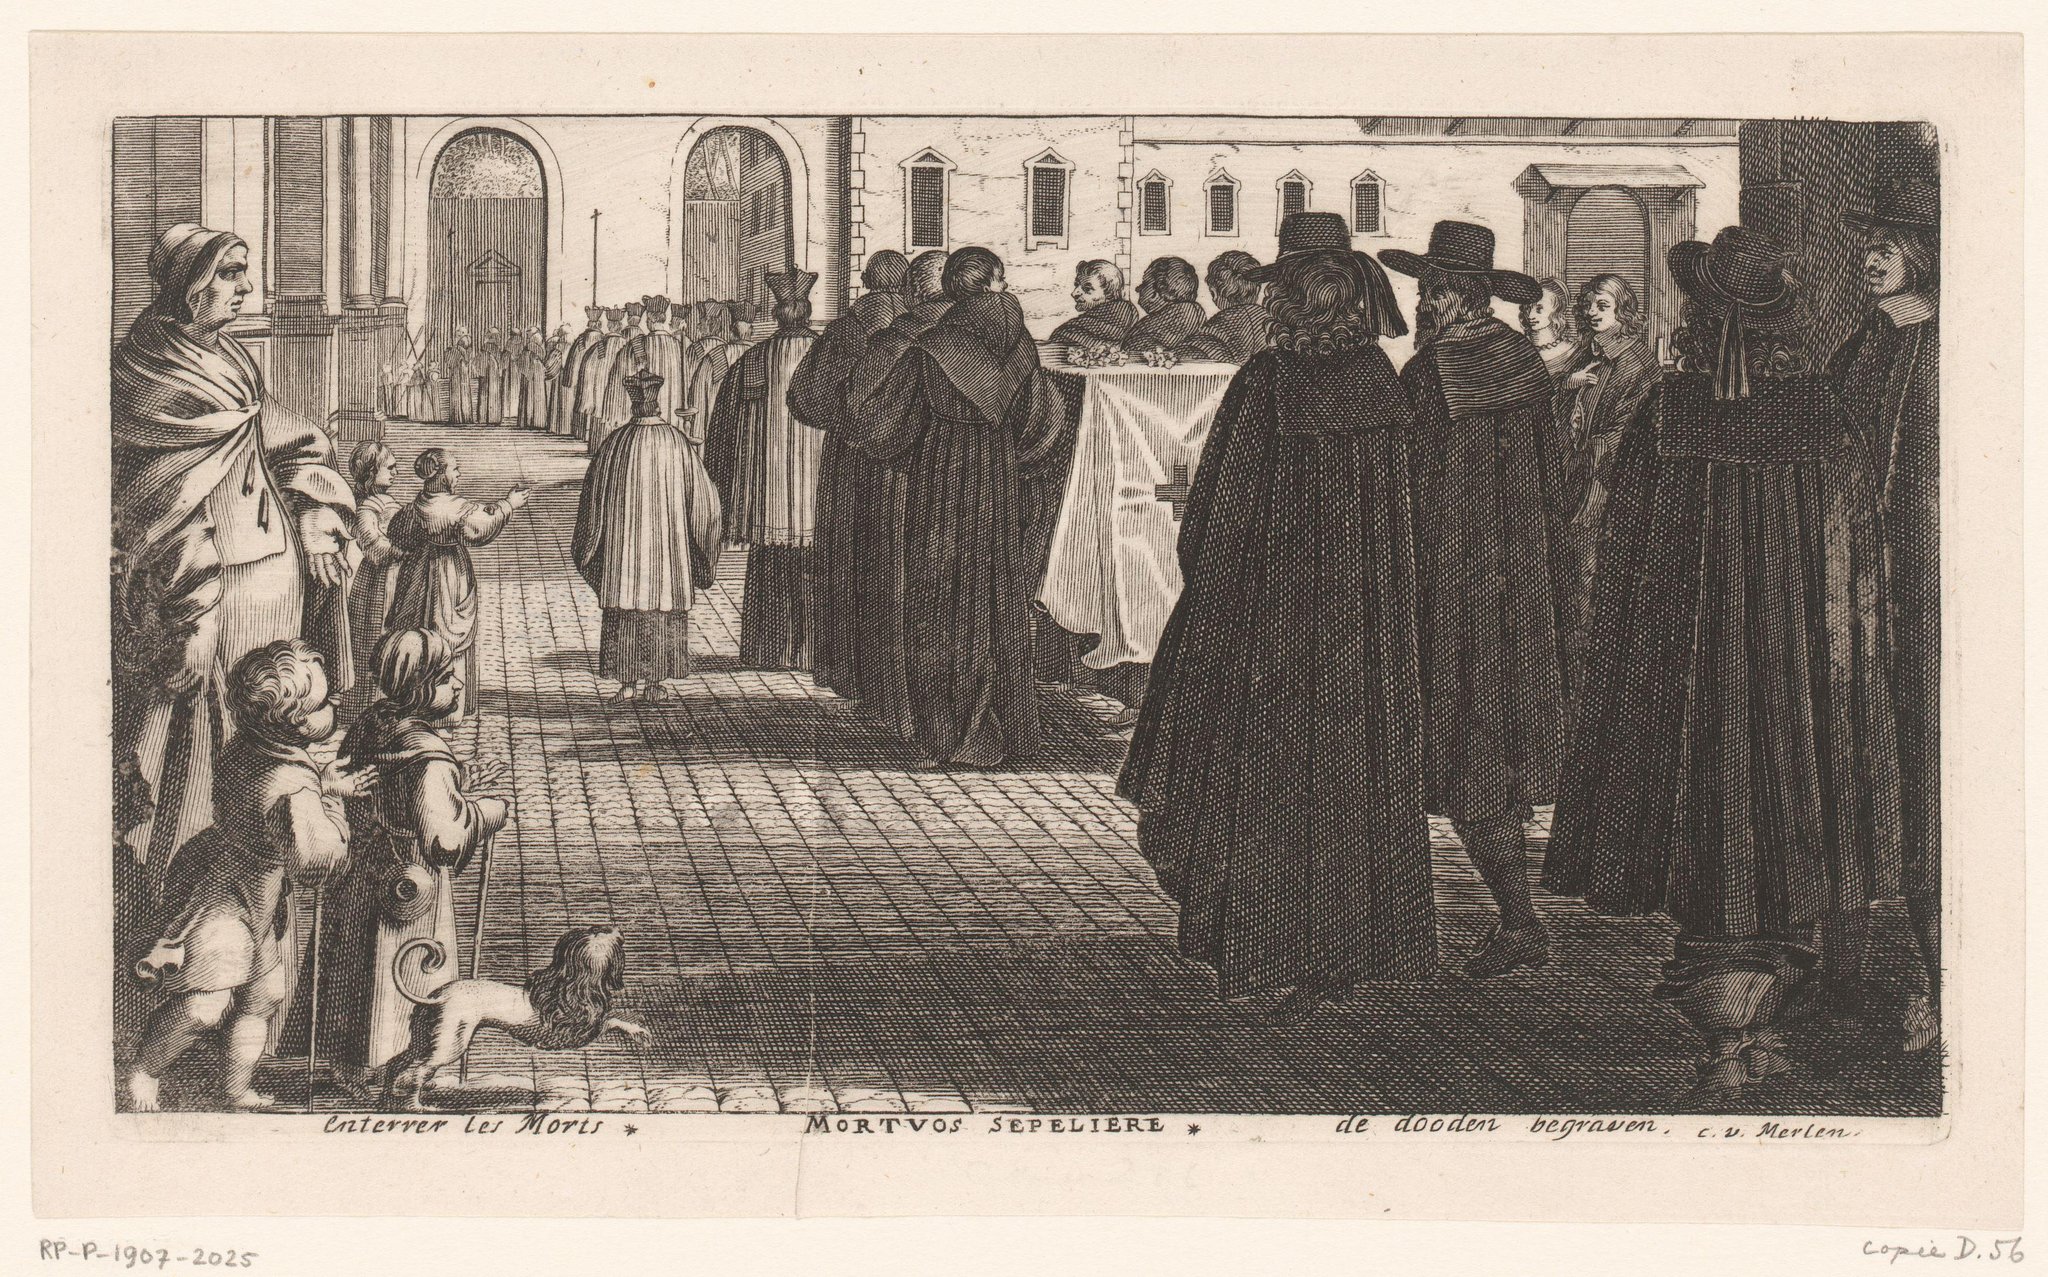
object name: print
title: Zeven werken van Barmhartigheid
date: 1664-1723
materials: paper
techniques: engraving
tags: burying the dead, 'mortuus sepellitur' ~ one of the (seven) acts of mercy, cortege, funeral procession, mourning dress, the (seven) acts of mercy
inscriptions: collector's mark: Lugt 2228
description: Betreft een gedeeltelijke, spiegelbeeldige kopie naar een prent door Abraham Bosse uit een serie van zeven prenten met als onderwerp de zeven werken van barmhartigheid, uitgegeven tussen 1640 en 1642 door Jean Leblond (I) in Parijs. Zie Lothe 2008, nrs. 22-28.